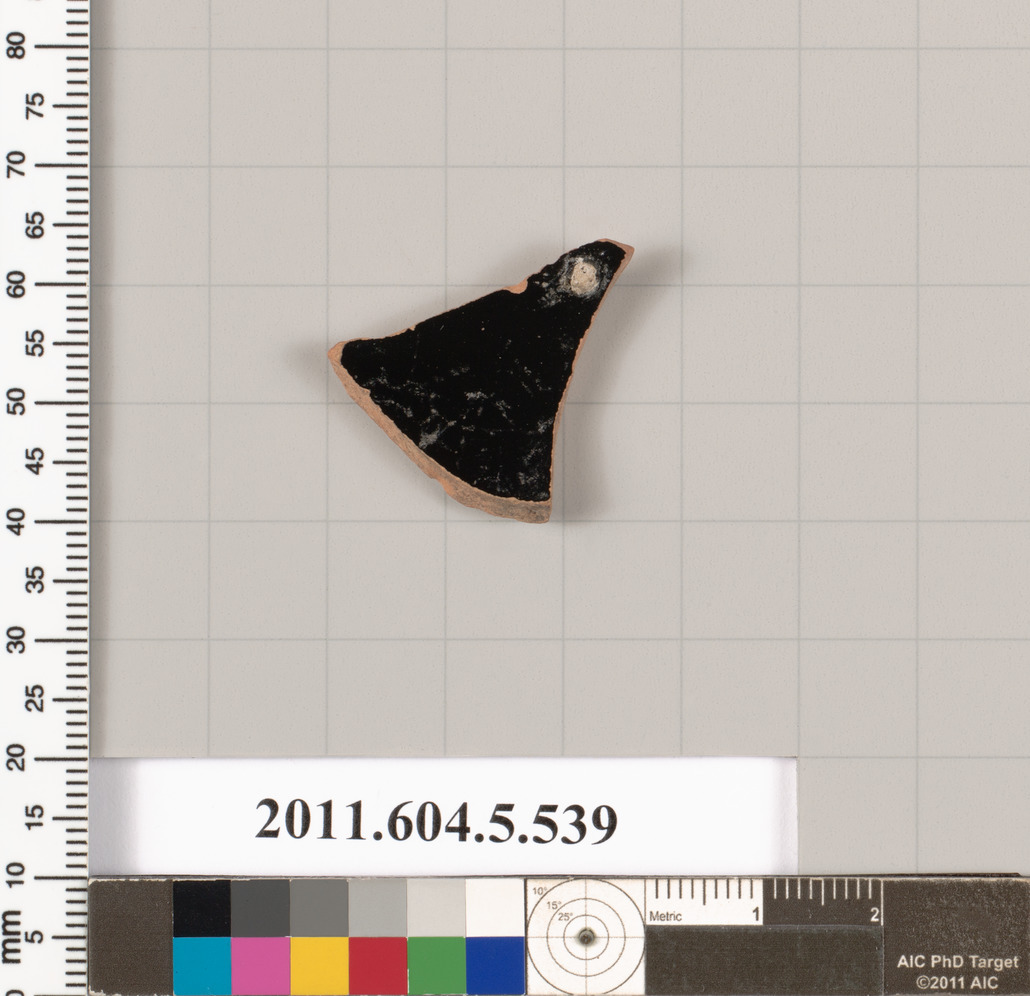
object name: kylix fragment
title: Terracotta fragment of a kylix (drinking cup)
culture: greek, attic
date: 600-401 BCE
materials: terracotta